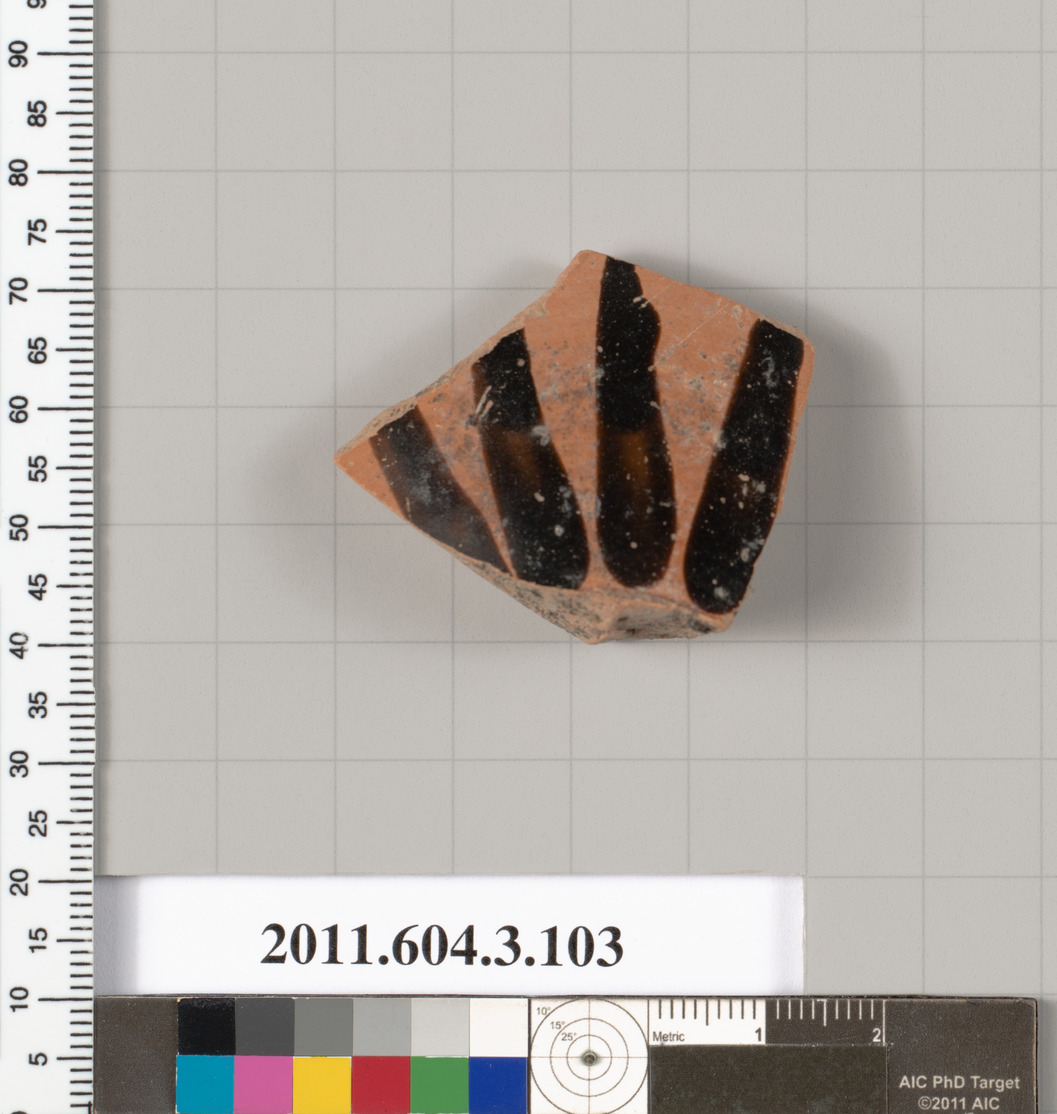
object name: amphora fragment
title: Terracotta fragment of an amphora (jar)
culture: greek, attic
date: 600-468 BCE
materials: terracotta